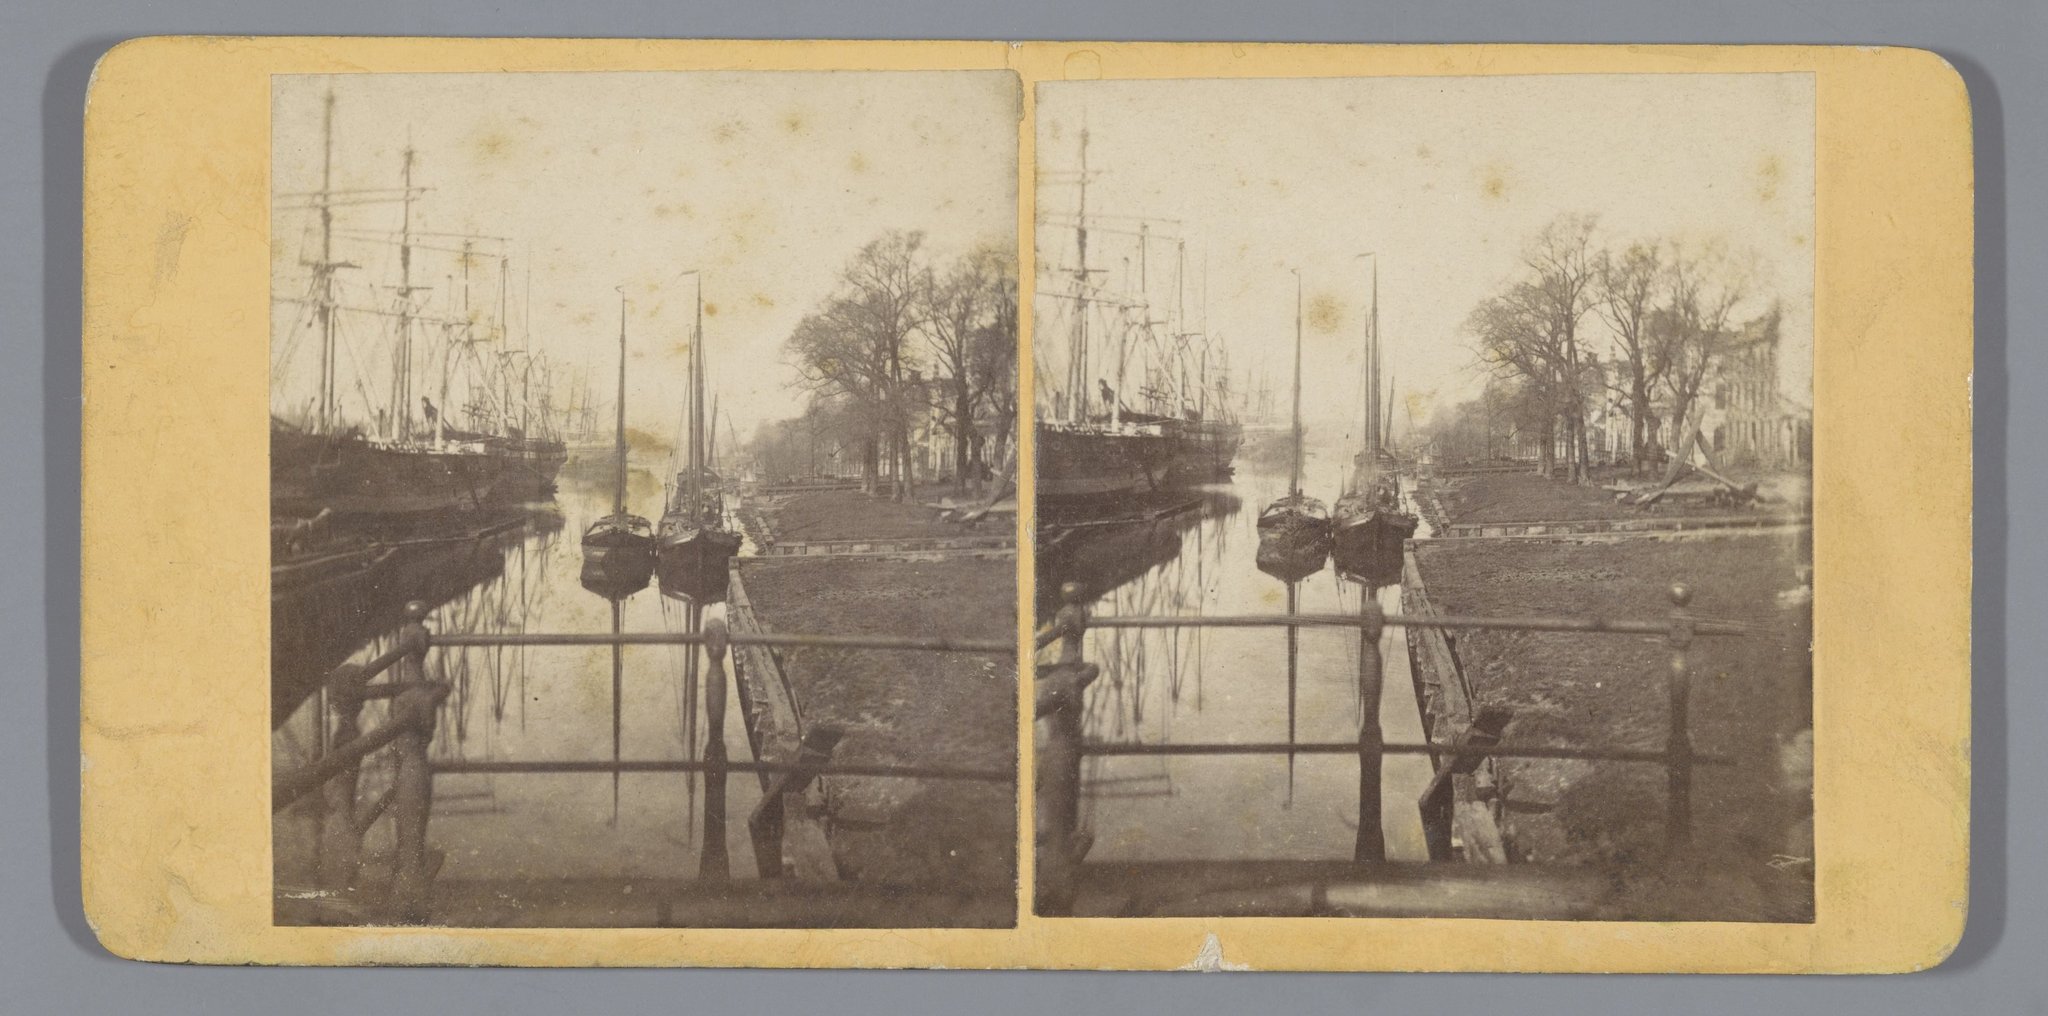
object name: stereograph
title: Schepen op de Nieuwe Vaart in Amsterdam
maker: Anonymous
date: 1861-1870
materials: cardboard, paper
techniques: albumen print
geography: amsterdam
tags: canals, waters (in city)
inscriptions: inscription: ‘Amsterdam/ Nieuwe Vaart’, inscription: ‘75 Ct’